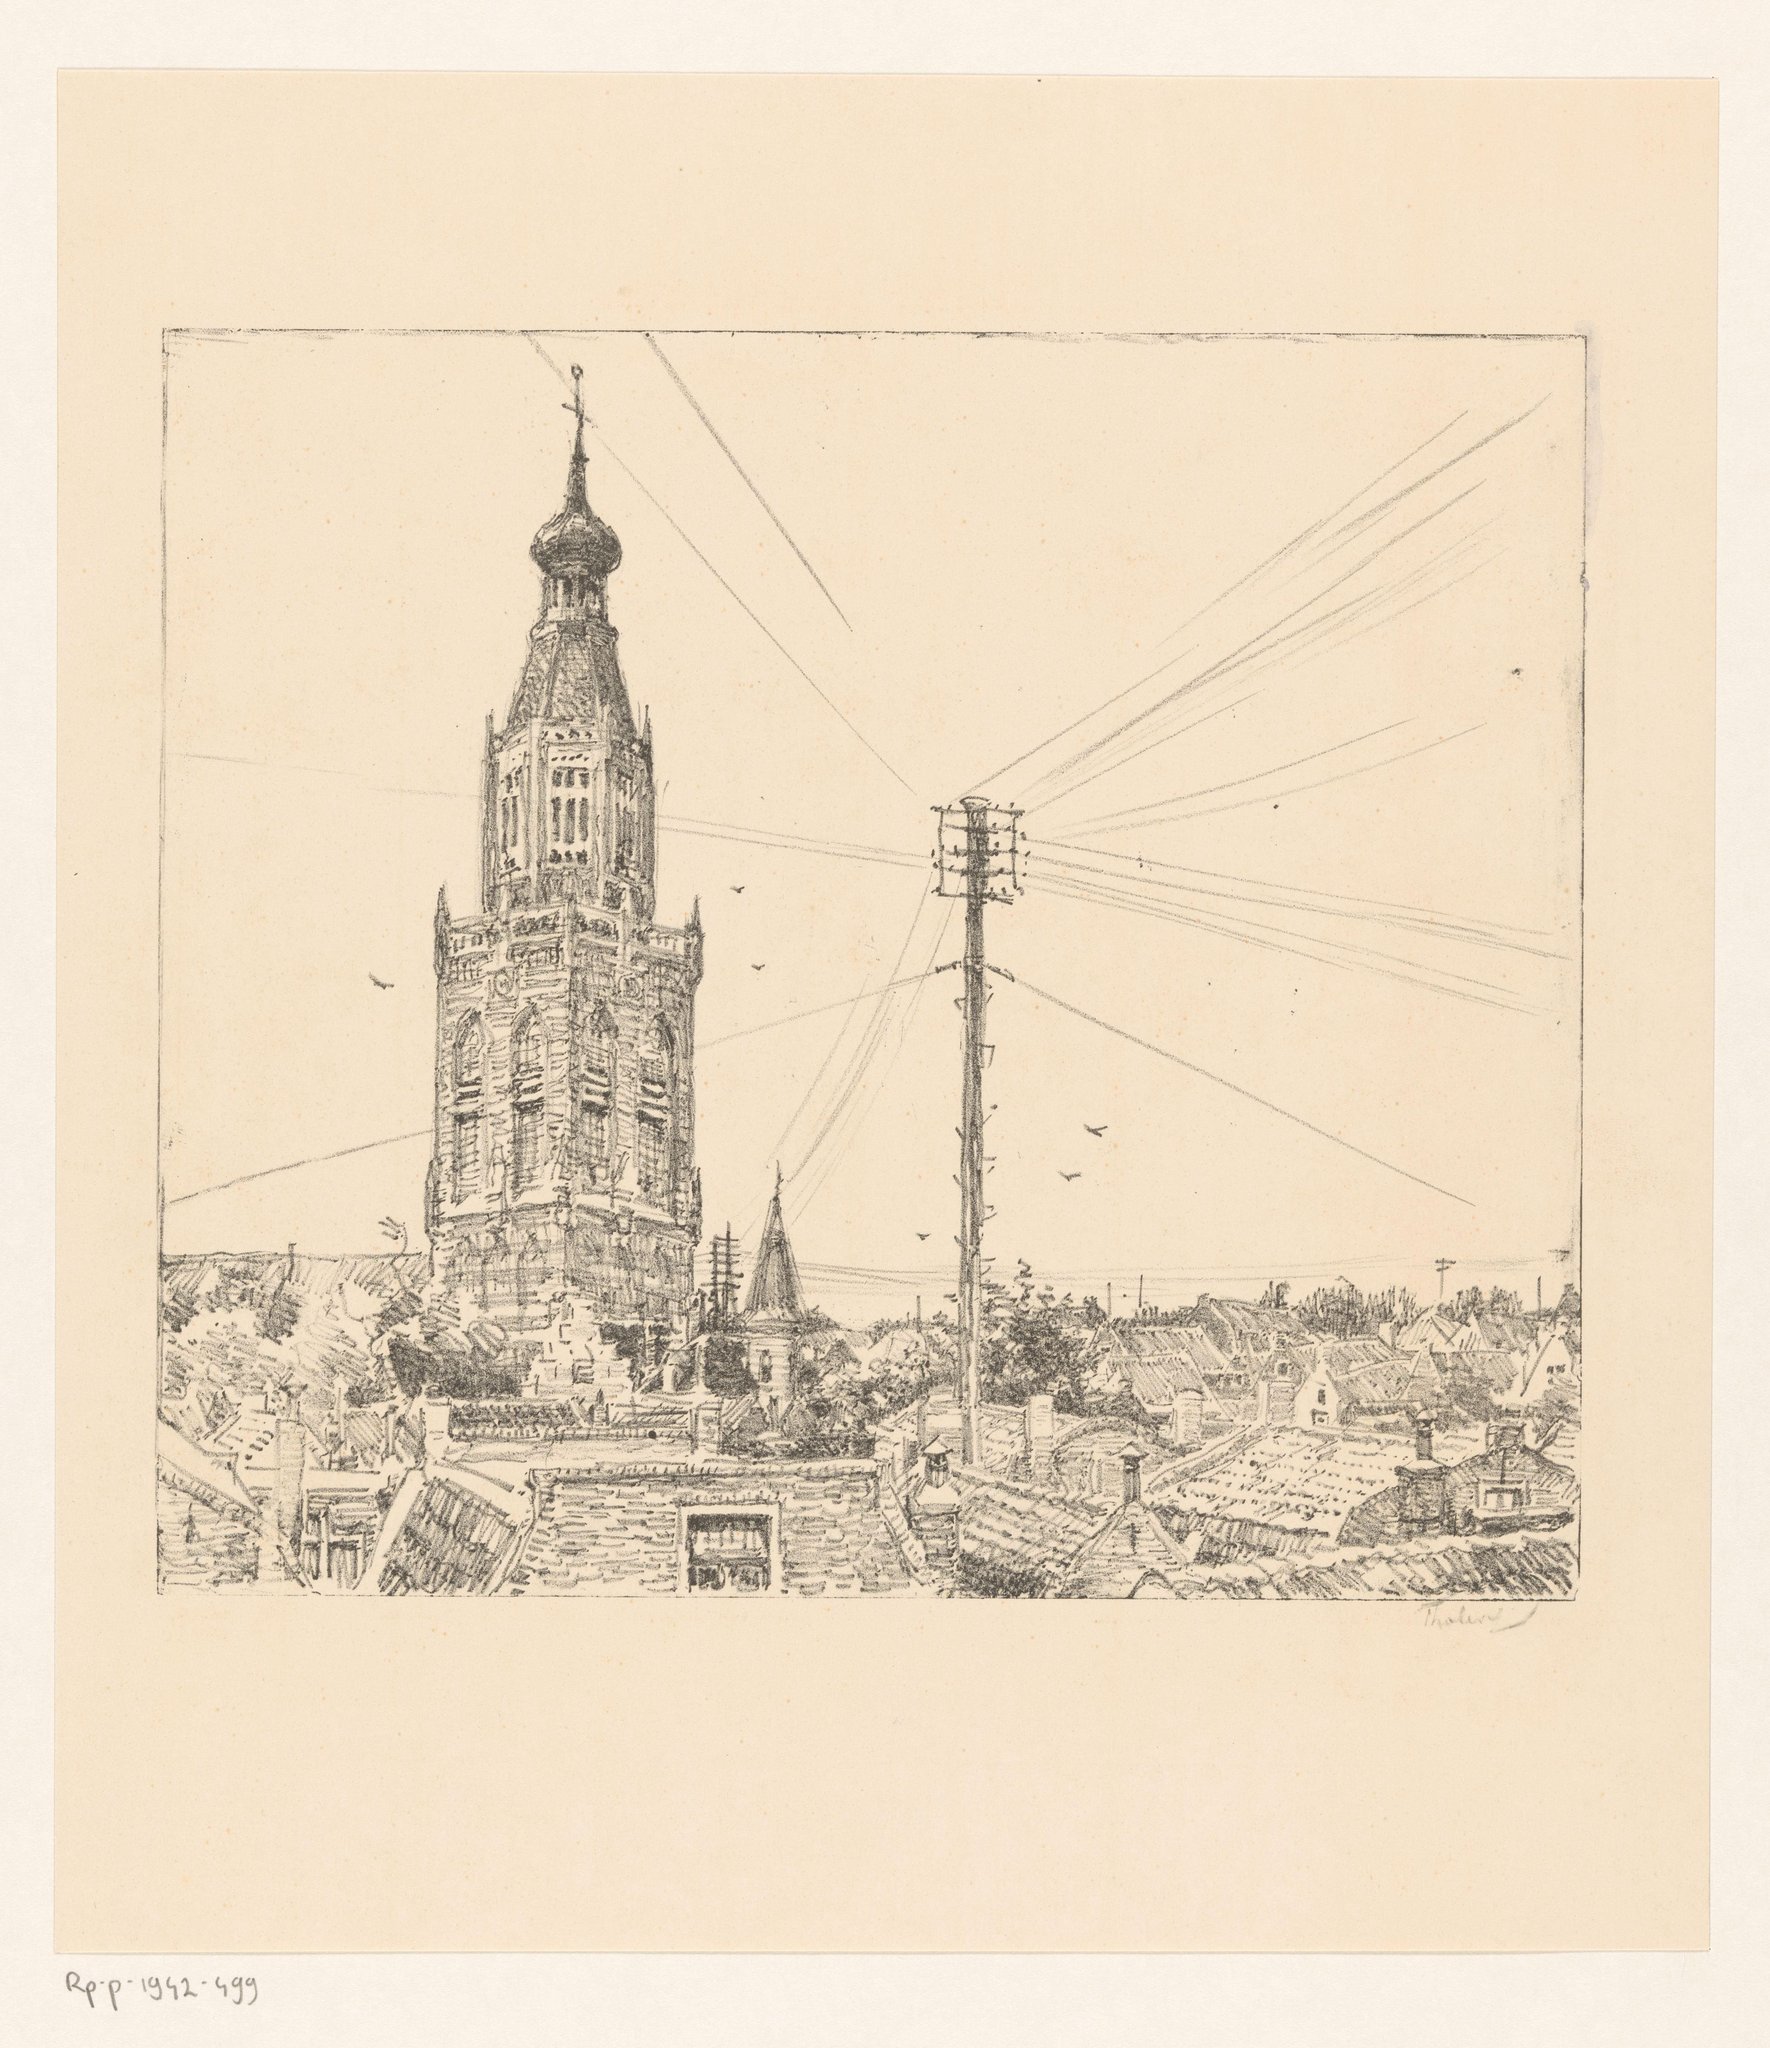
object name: print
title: Gezicht op Enkhuizen met de toren van de Zuiderkerk en een telefoonmast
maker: willem bastiaan tholen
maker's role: draughtsman, painter, print maker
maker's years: 1860-1931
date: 1905-1920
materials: paper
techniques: lithograph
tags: telegraph pole, telephone pole, church (exterior), prospect of city, town panorama, silhouette of city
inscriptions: collector's mark: Lugt 2228